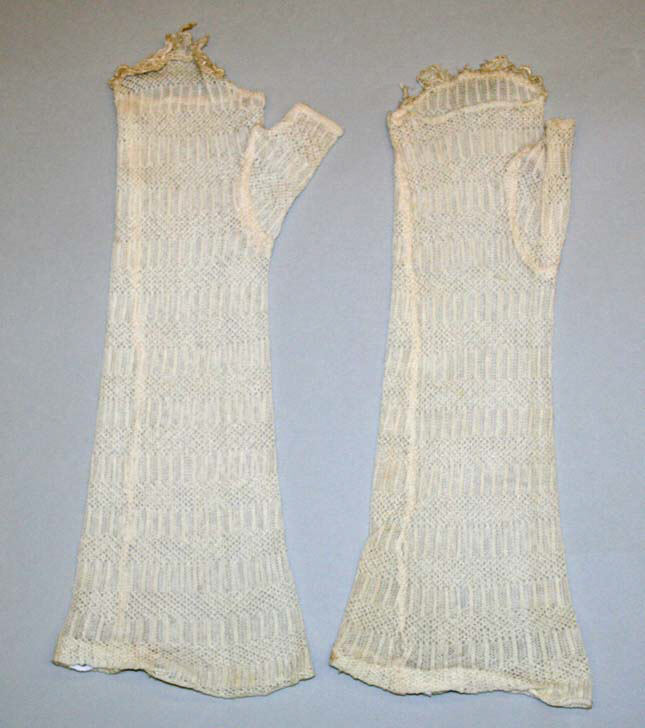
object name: mitt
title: Mitts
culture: american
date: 1865-1869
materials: cotton, silk